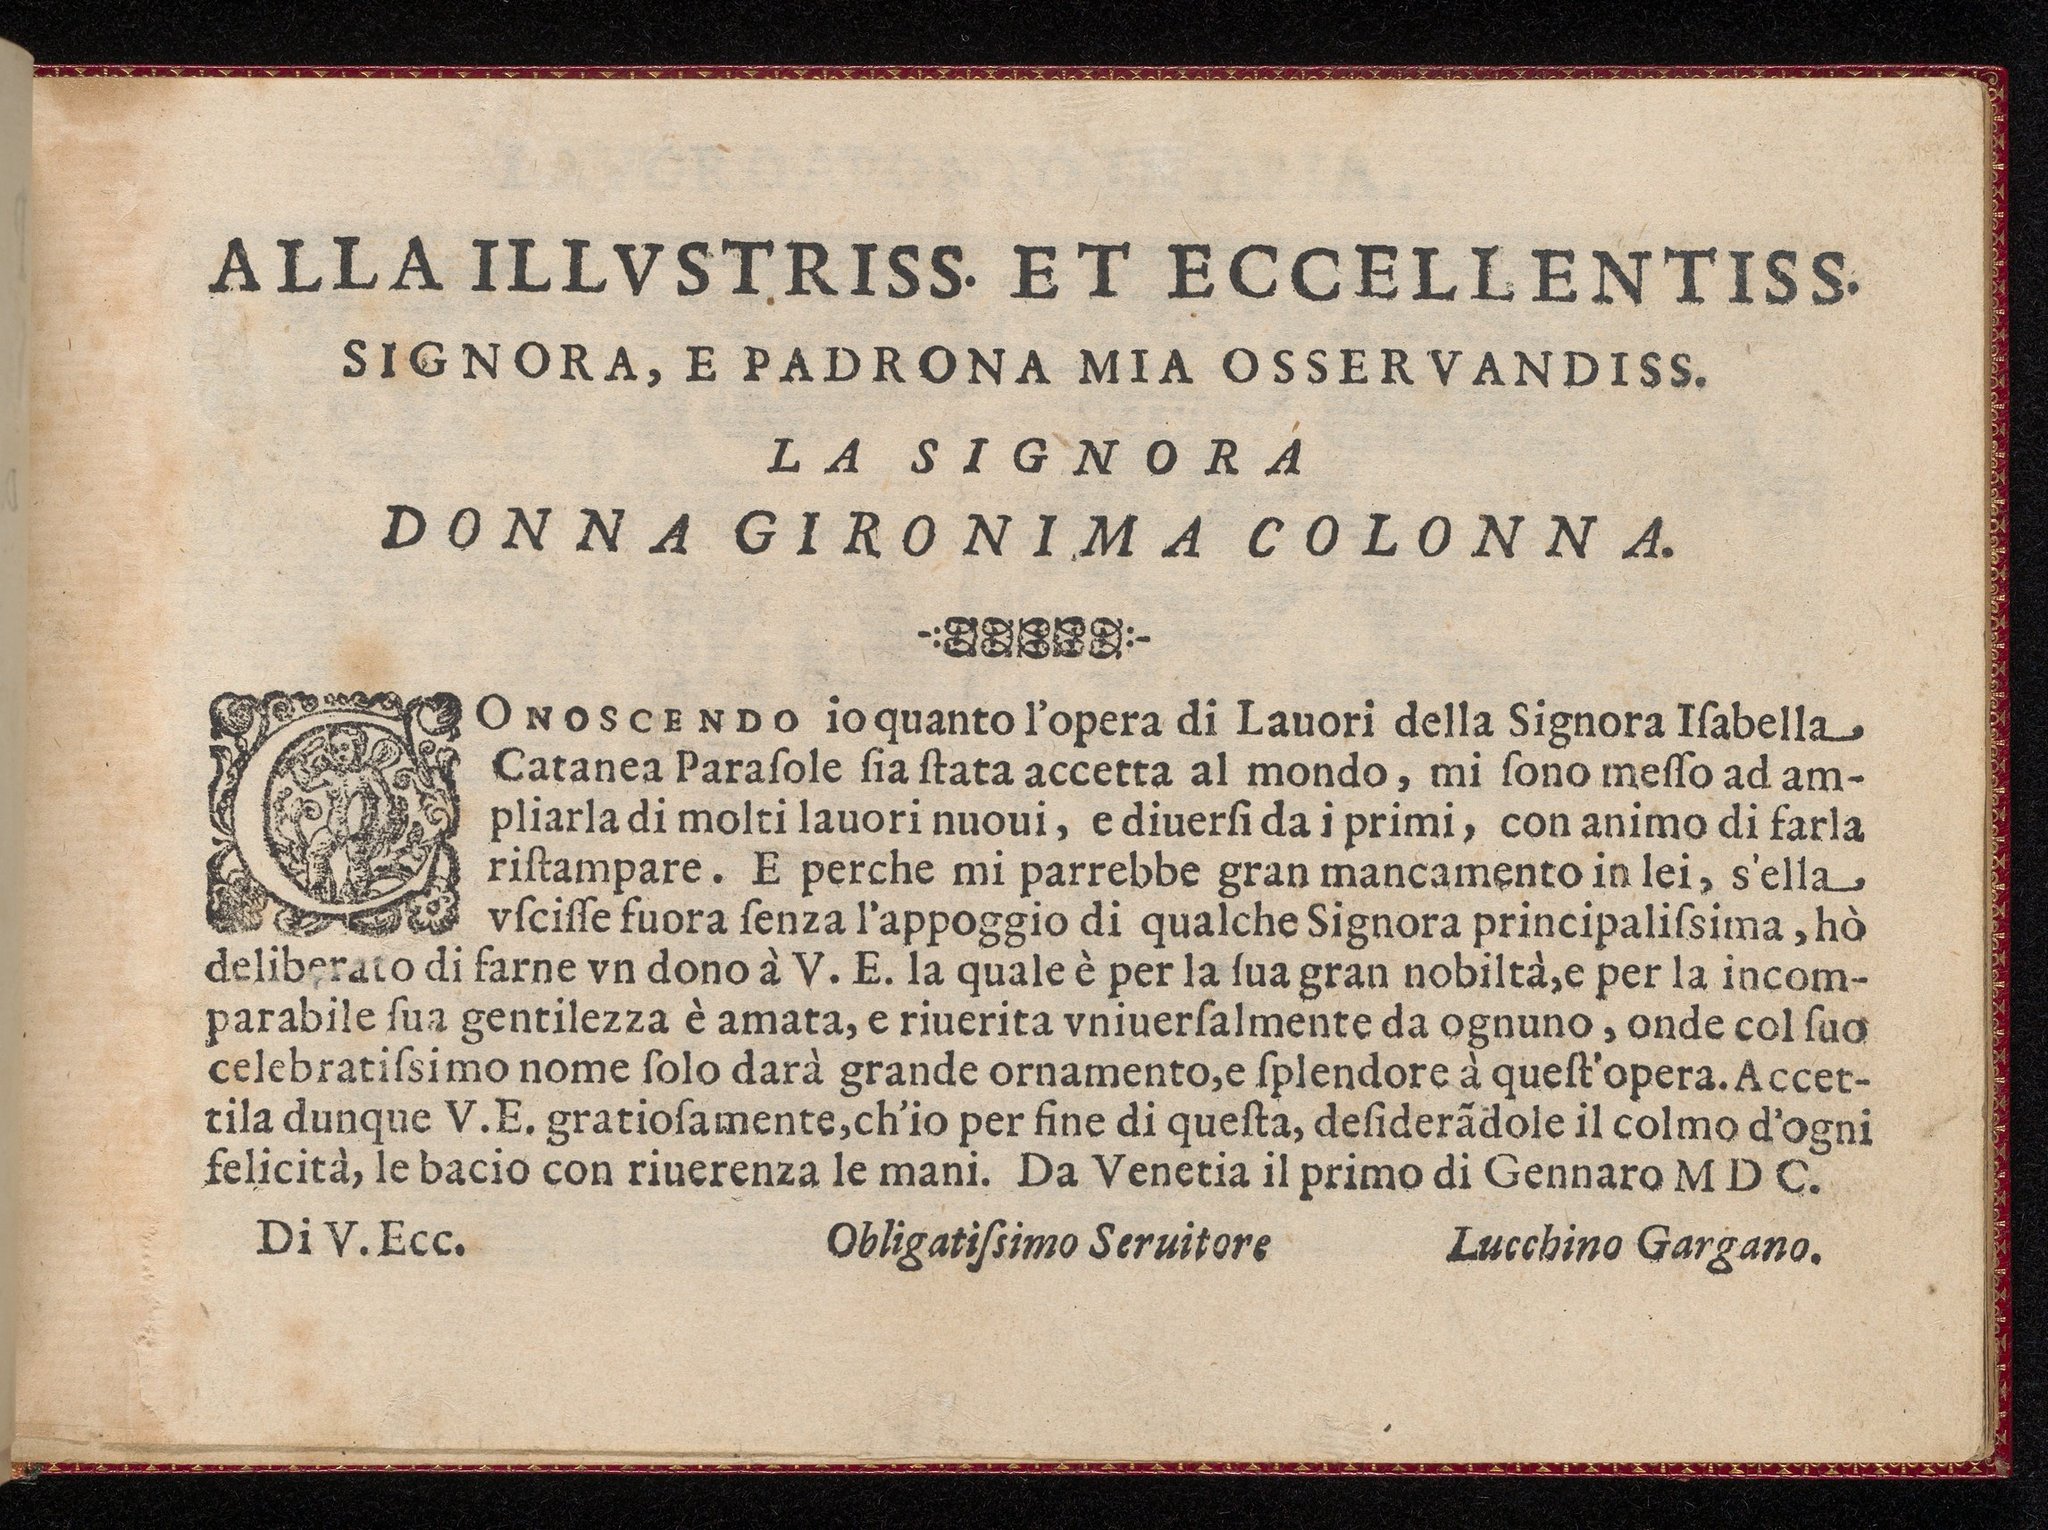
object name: book print ornament architecture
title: Pretiosa Gemma delle virtuose donne, page 2 (recto)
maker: isabella catanea parasole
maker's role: author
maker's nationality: italian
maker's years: 1565-1625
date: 1600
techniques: woodcut